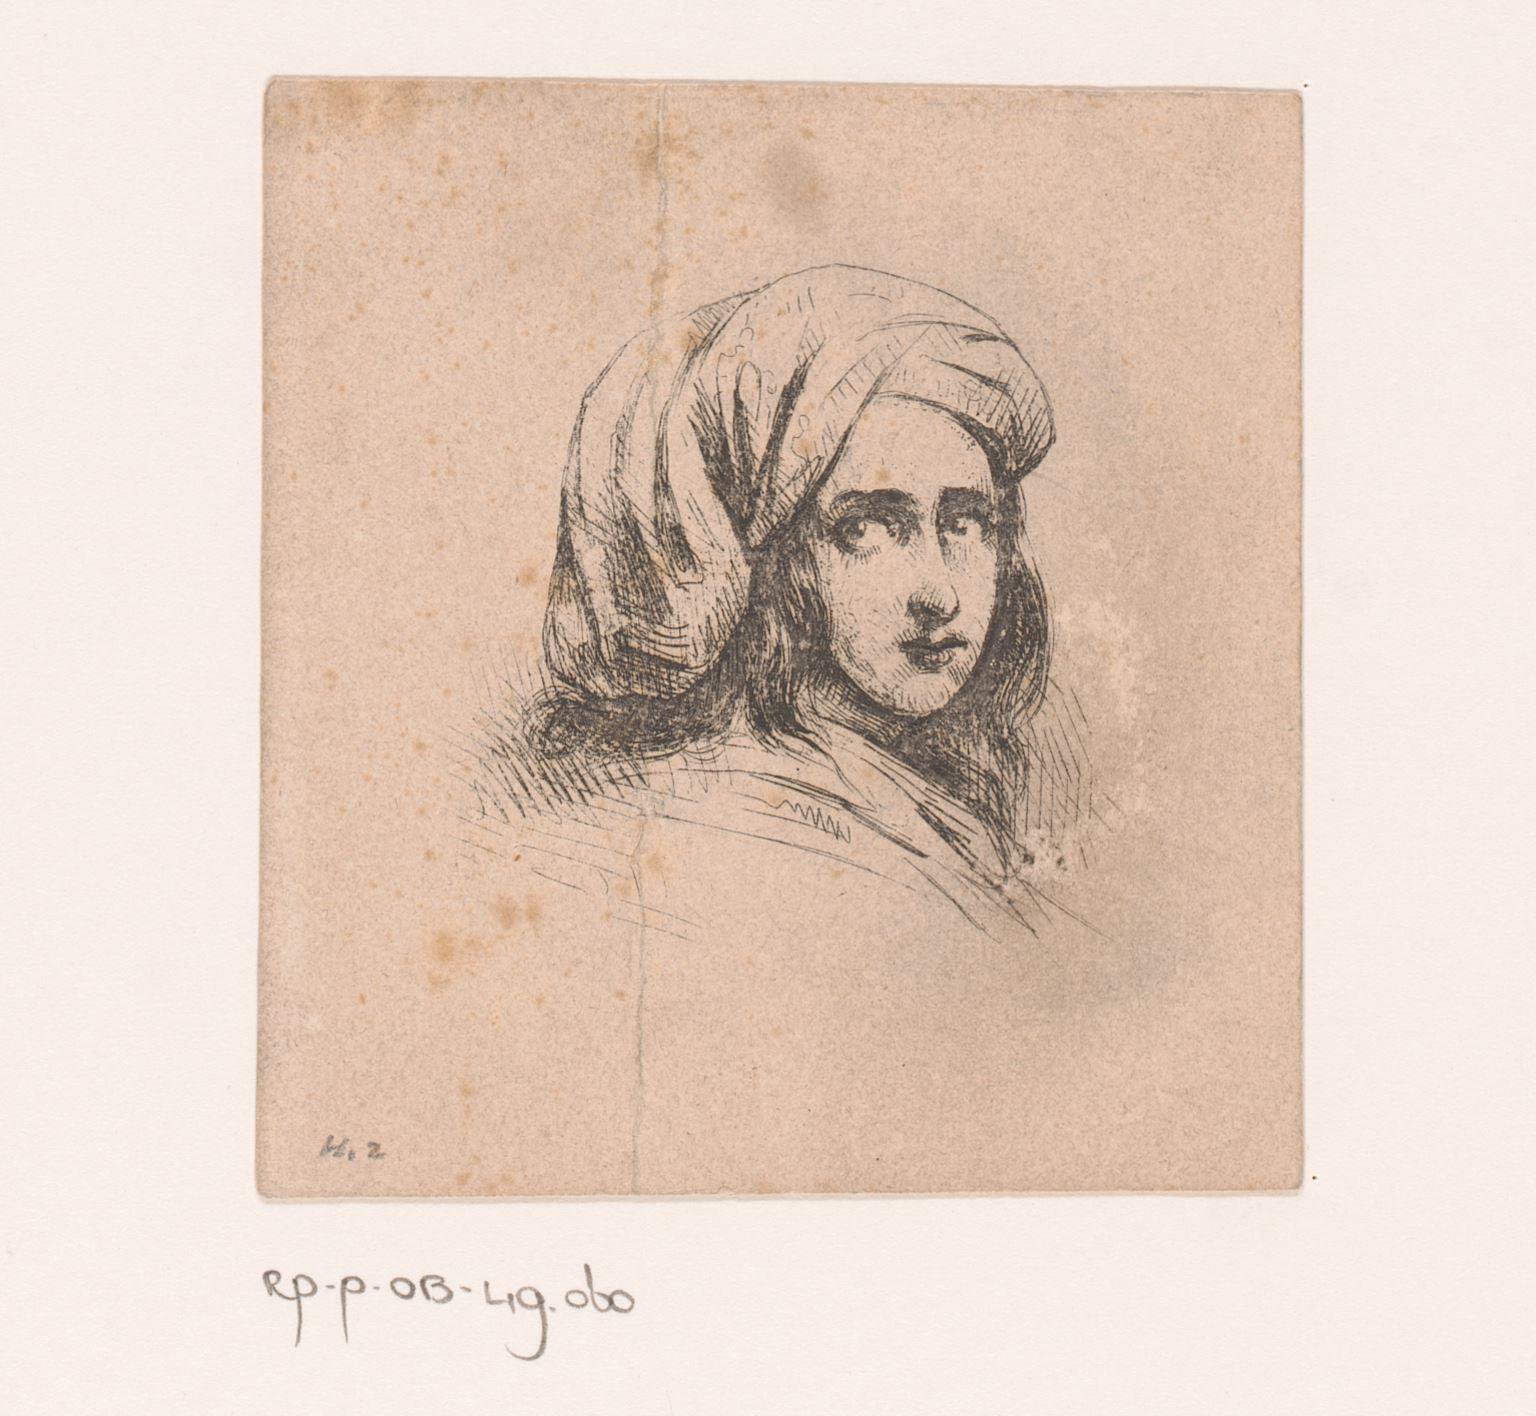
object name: print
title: Portret van een onbekende vrouw met tulband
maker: henri grégoir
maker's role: painter, print maker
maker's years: 1818-1853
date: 1828-1853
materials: paper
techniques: etching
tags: anonymous historical person portrayed - bb - woman